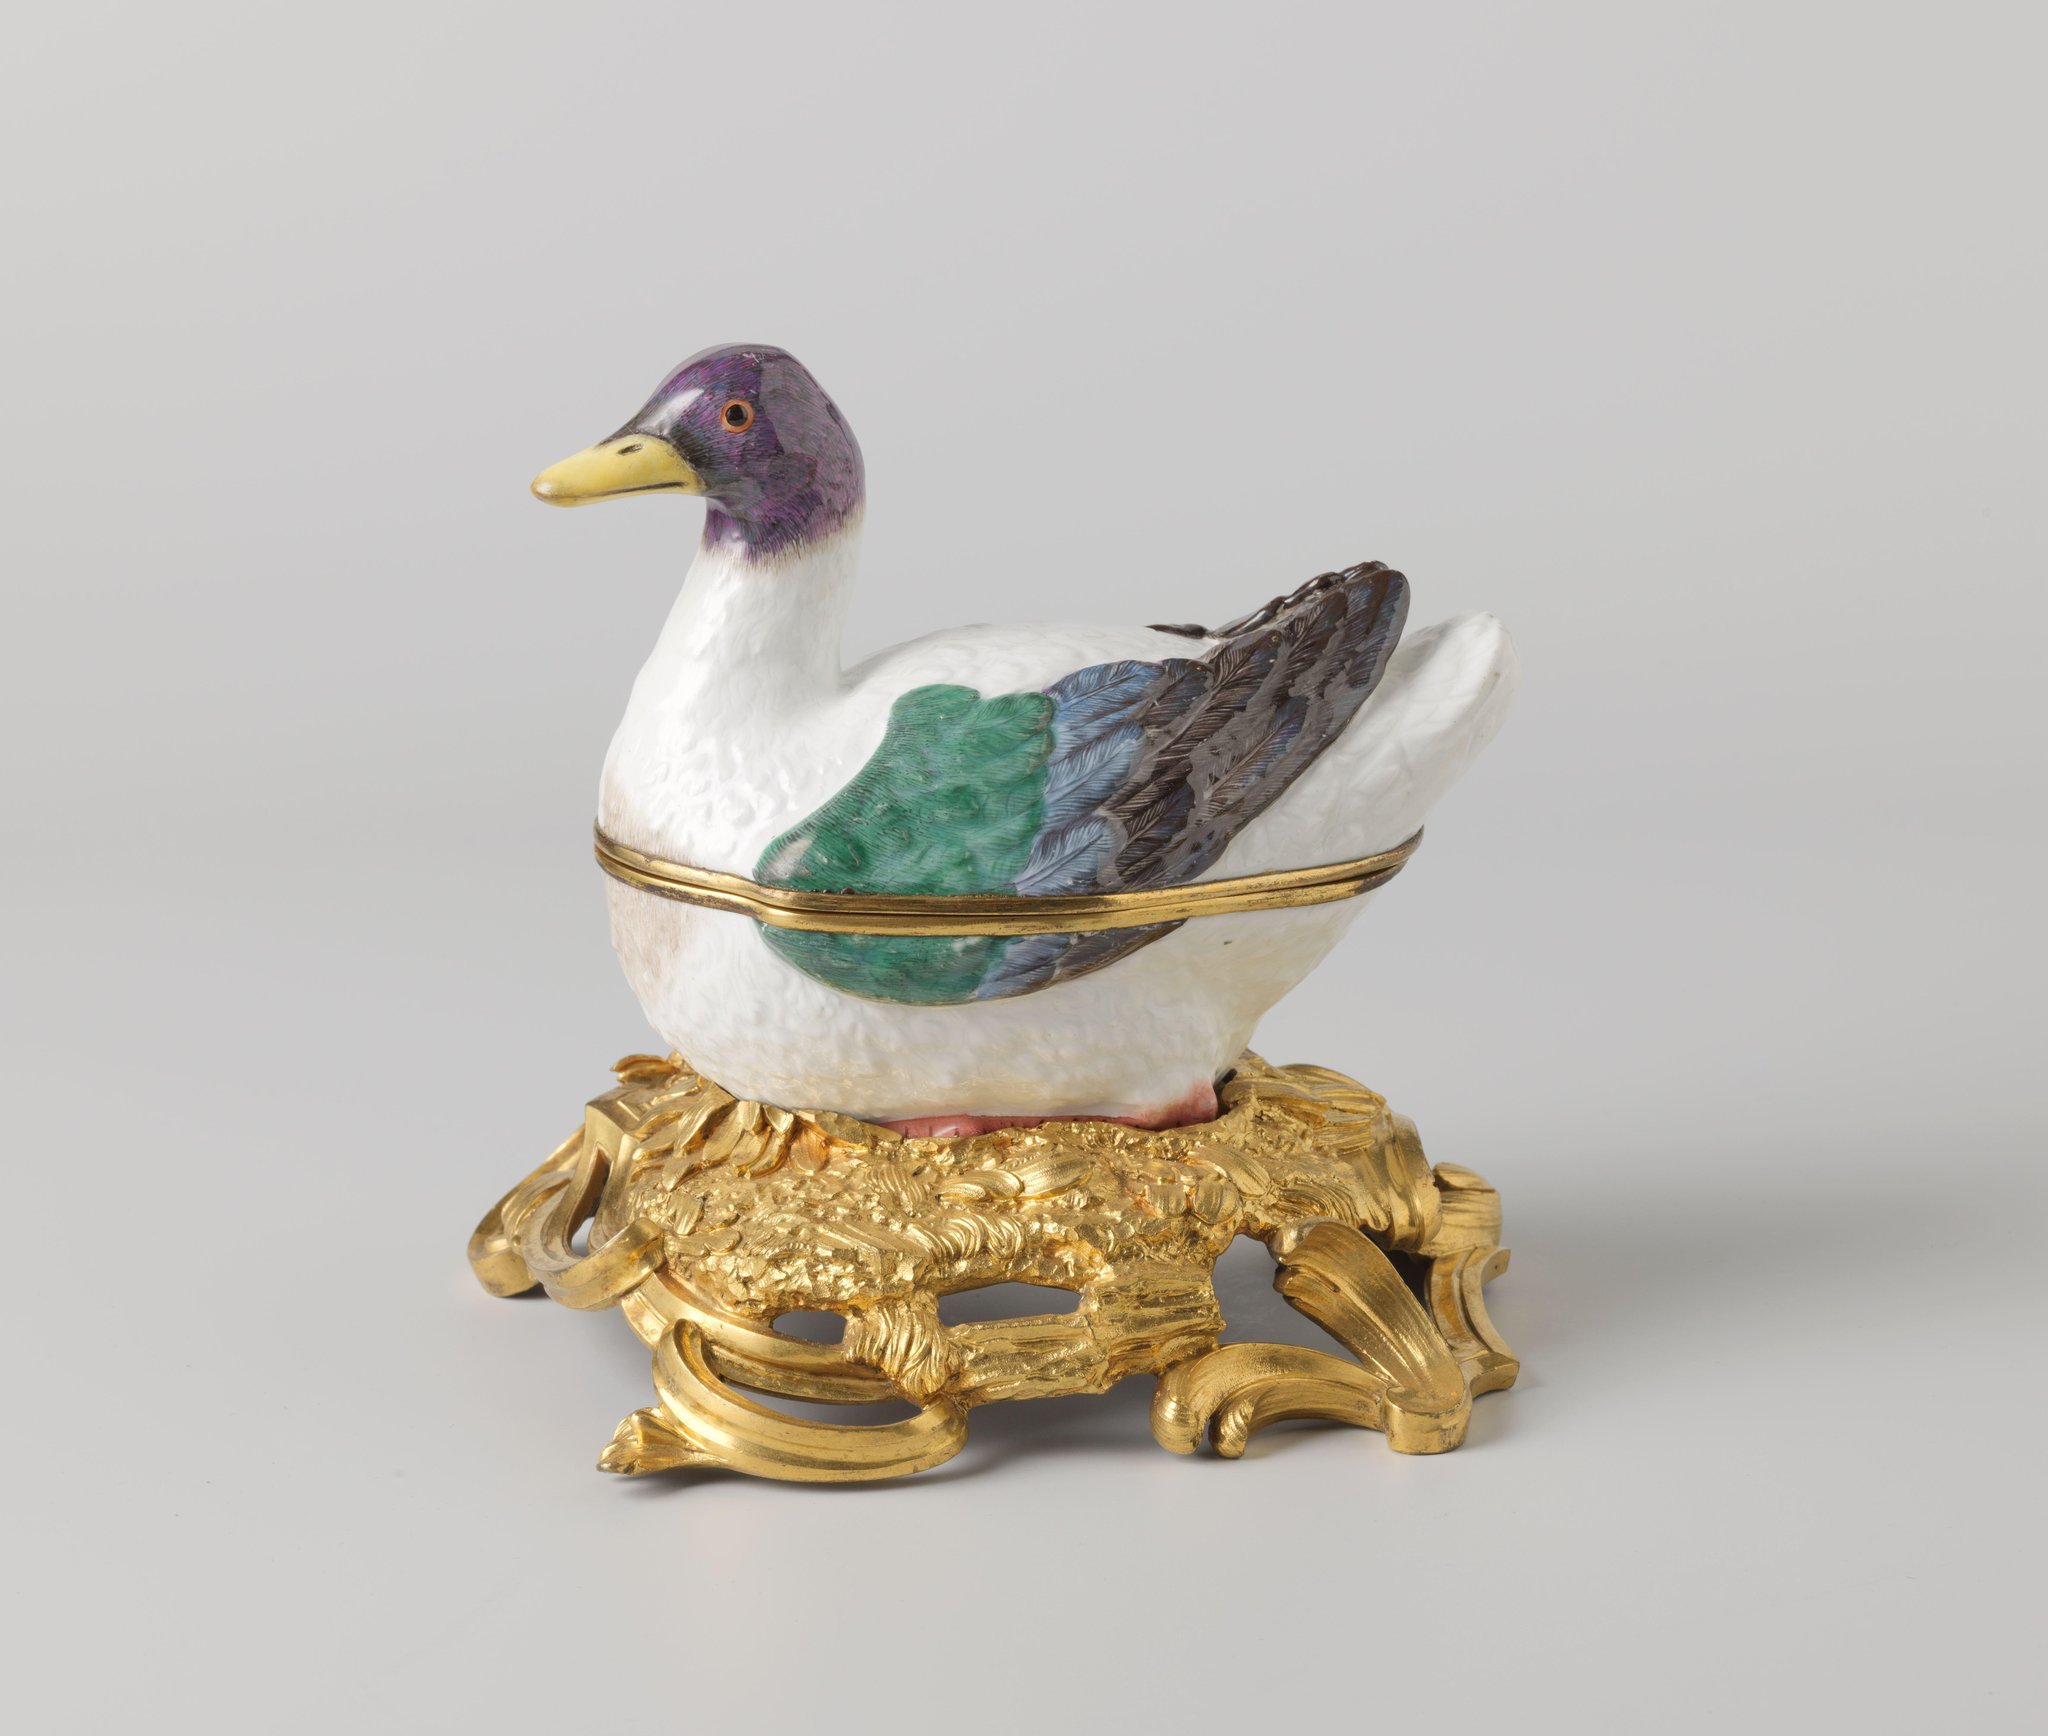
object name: box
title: Doos met deksel in de vorm van een eend op voetstuk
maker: johann joachim kändler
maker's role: designer, sculptor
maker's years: 1706-1775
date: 1740-1748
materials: bronze, porcelain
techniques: gilding, painted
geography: meissen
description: Two tureens in the form of a duck. Porcelain and gilt bronze. Meissen, c. 1740 - 1748, the model by Johann Joachim Kändler, the bronze France, c. 1750.